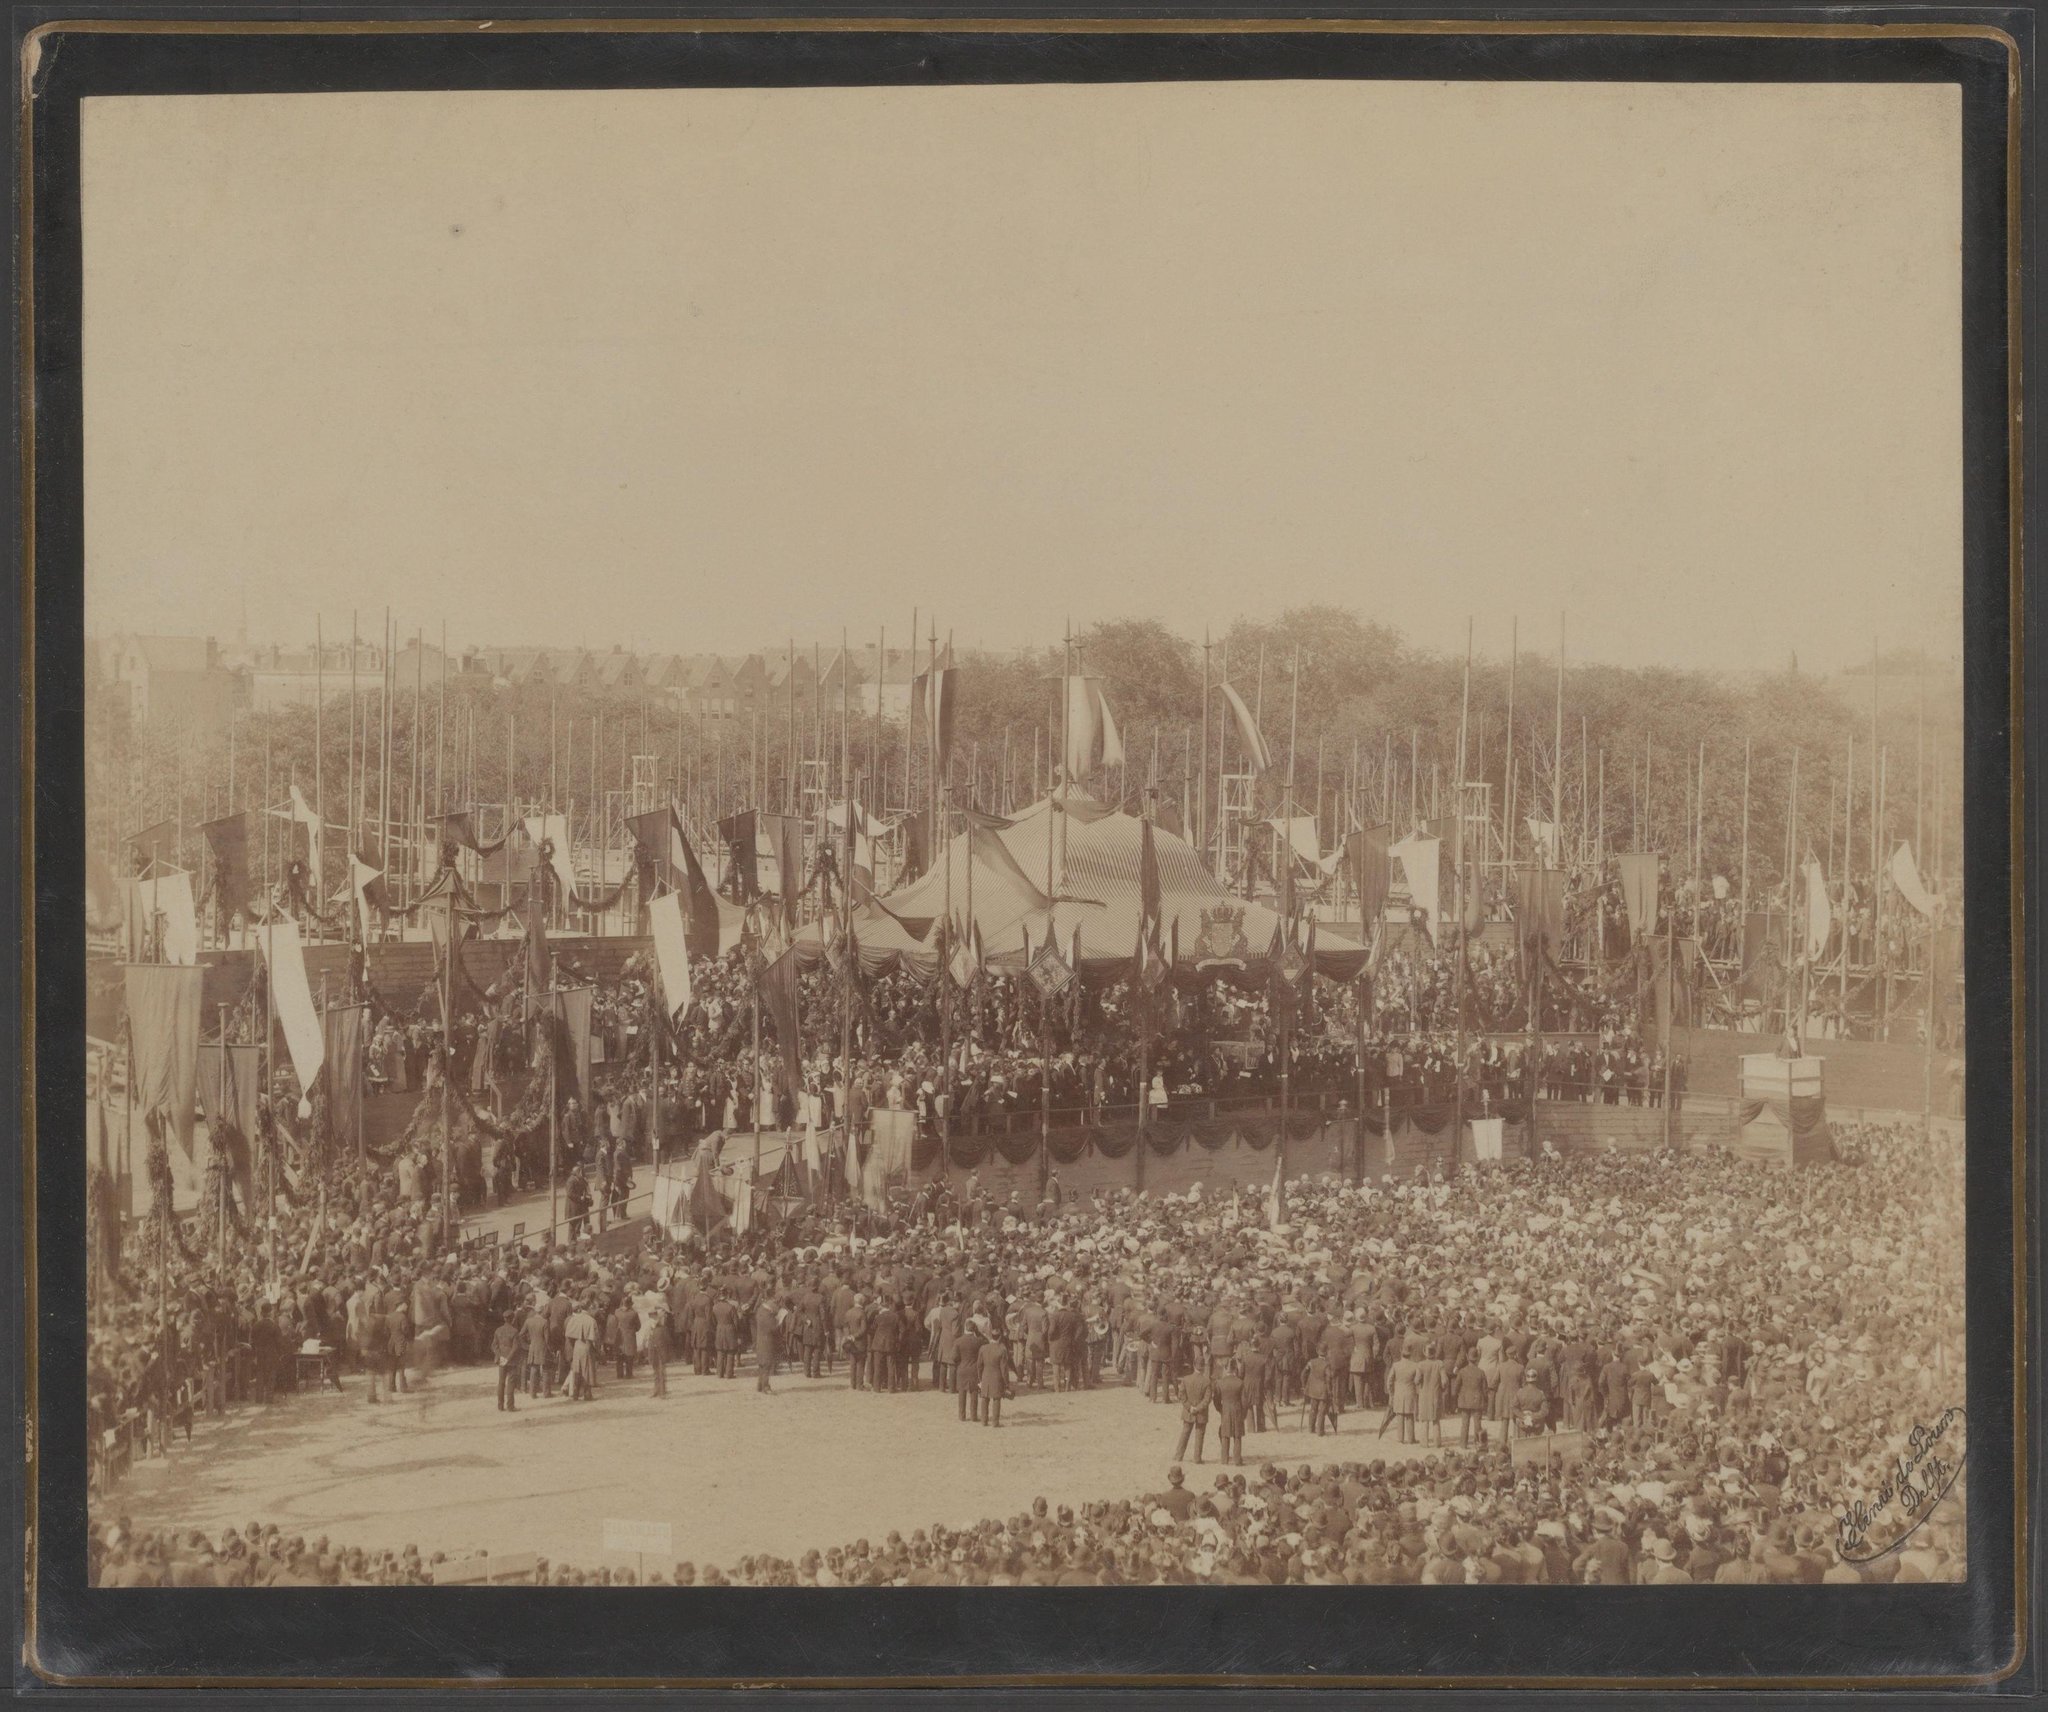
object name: photograph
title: Eerstesteenlegging van het Wilhelmina Gasthuis, 1891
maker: henri de louw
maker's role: fotograaf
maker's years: 1851-1944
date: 1805-1891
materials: cardboard, paper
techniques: albumen print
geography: delft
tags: ceremonial laying of the foundations, laying the first stone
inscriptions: collector's mark: Lugt 1641b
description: Onderwerpsrubriek binnen de Atlas Amsterdam: Armwezen en liefdadige instellingen: I. Stadsinrichtingen: Wilhelminagasthuis.